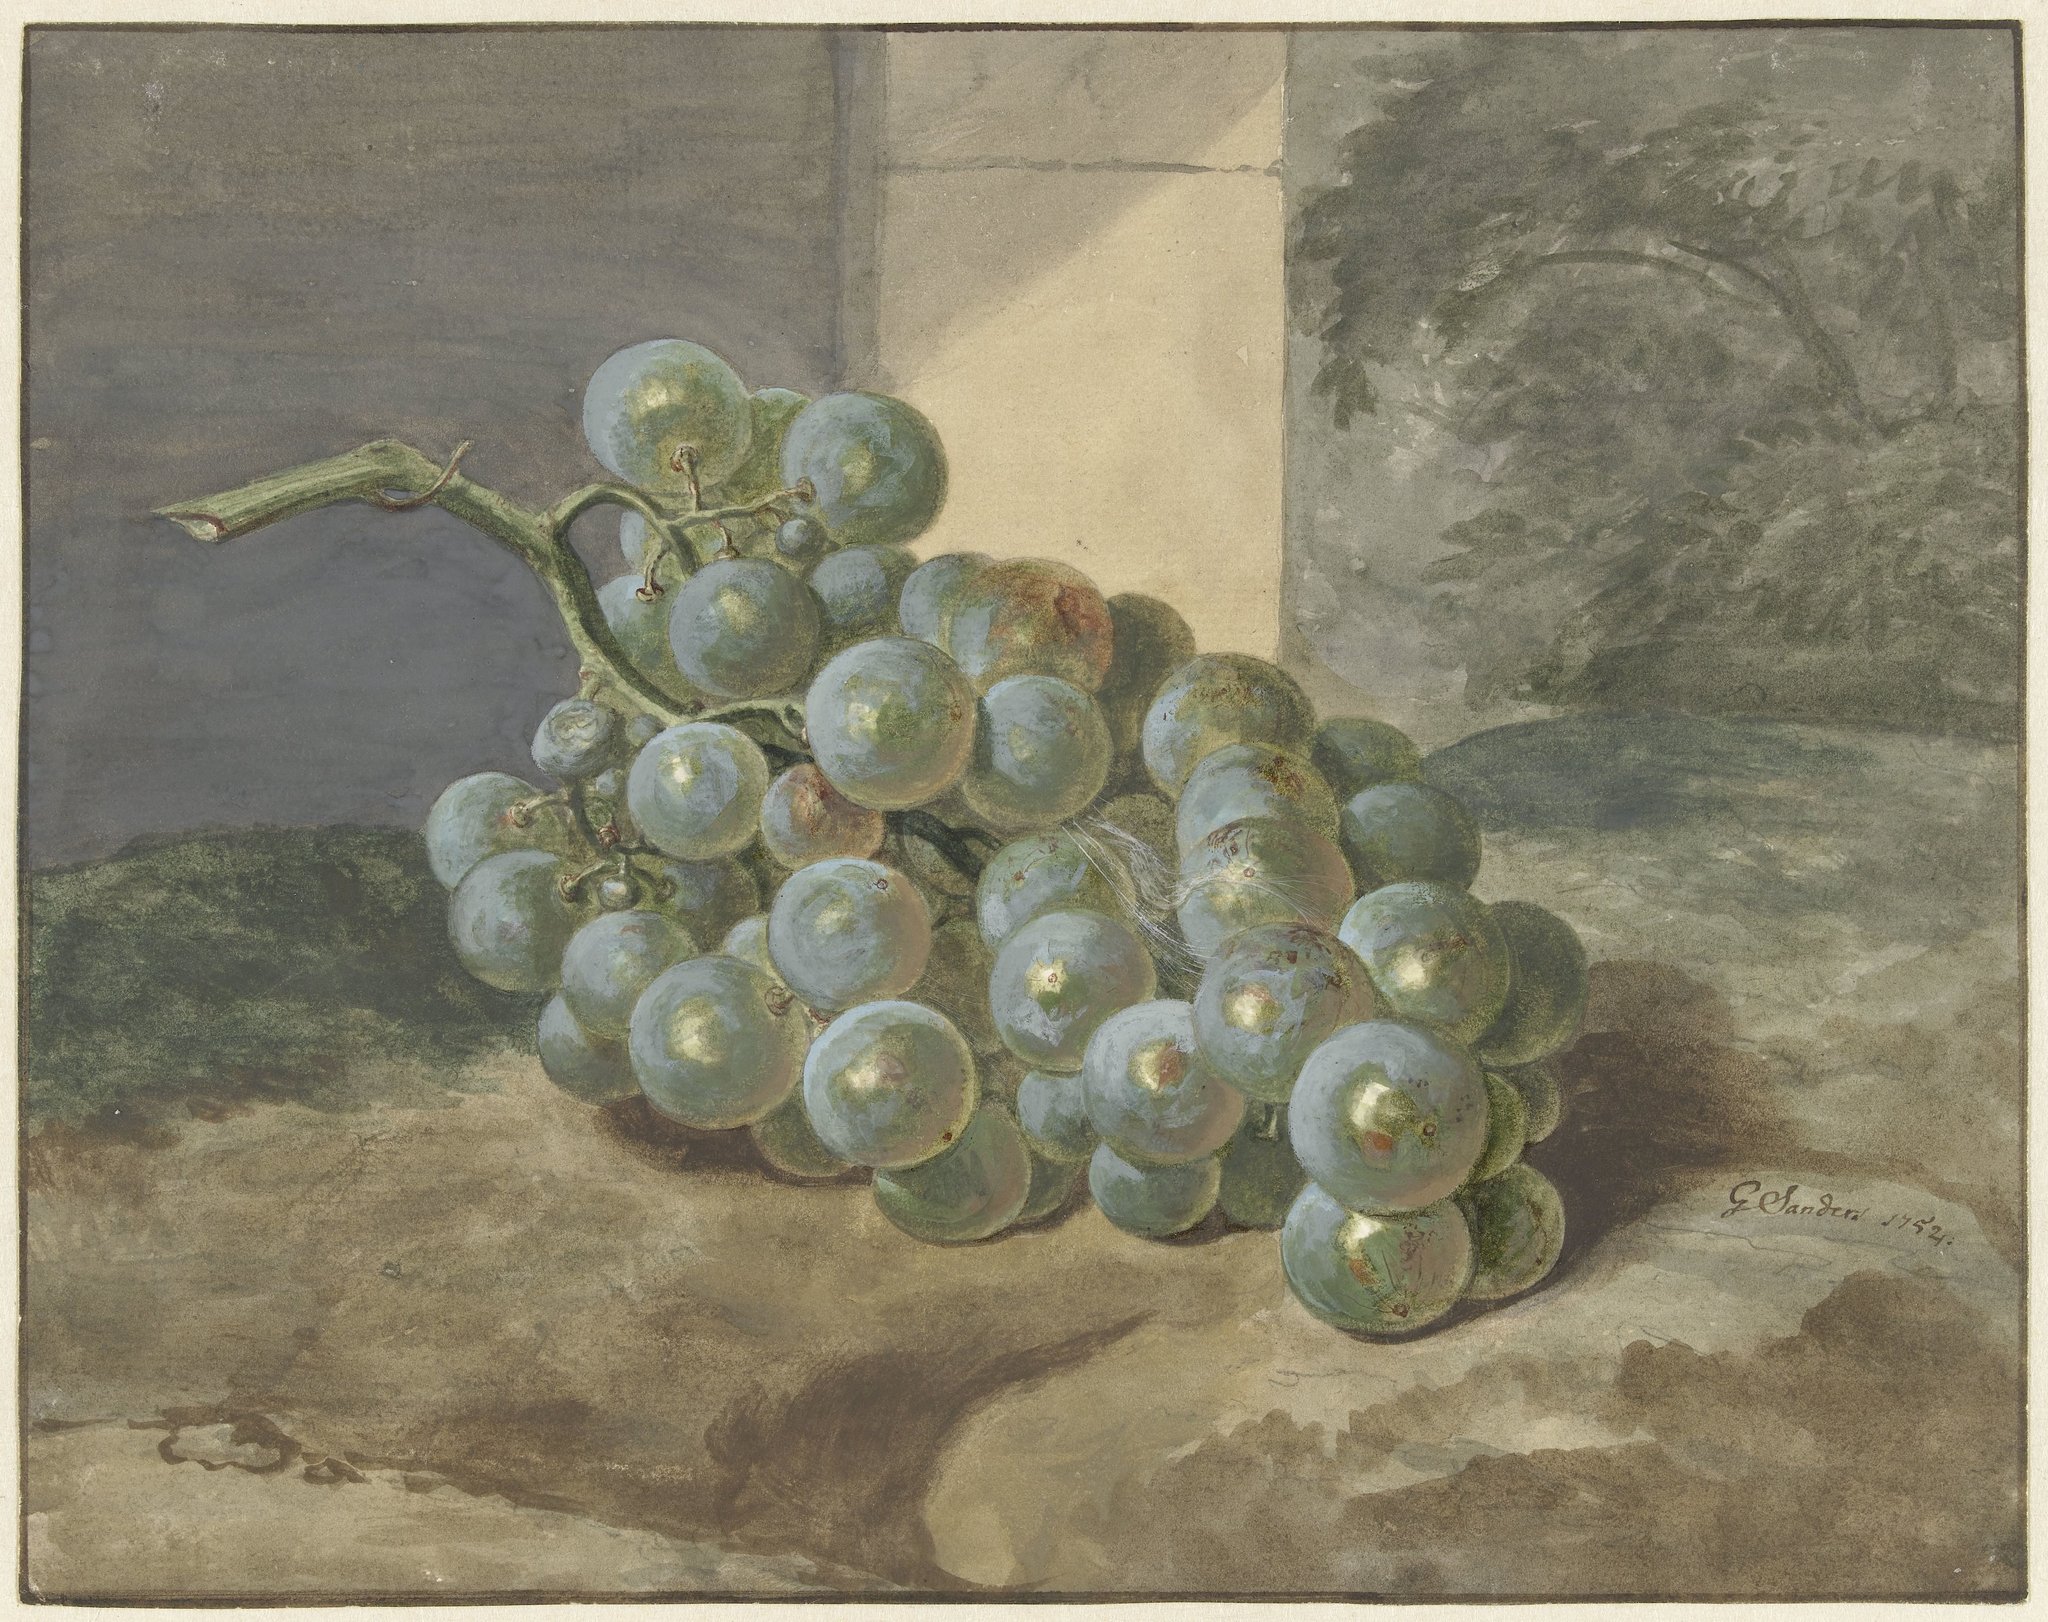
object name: drawing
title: Druiventros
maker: gerard sanders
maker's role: draughtsman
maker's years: 1702-1767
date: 1754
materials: paper, pencil, watercolor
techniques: brush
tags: bunch of grapes